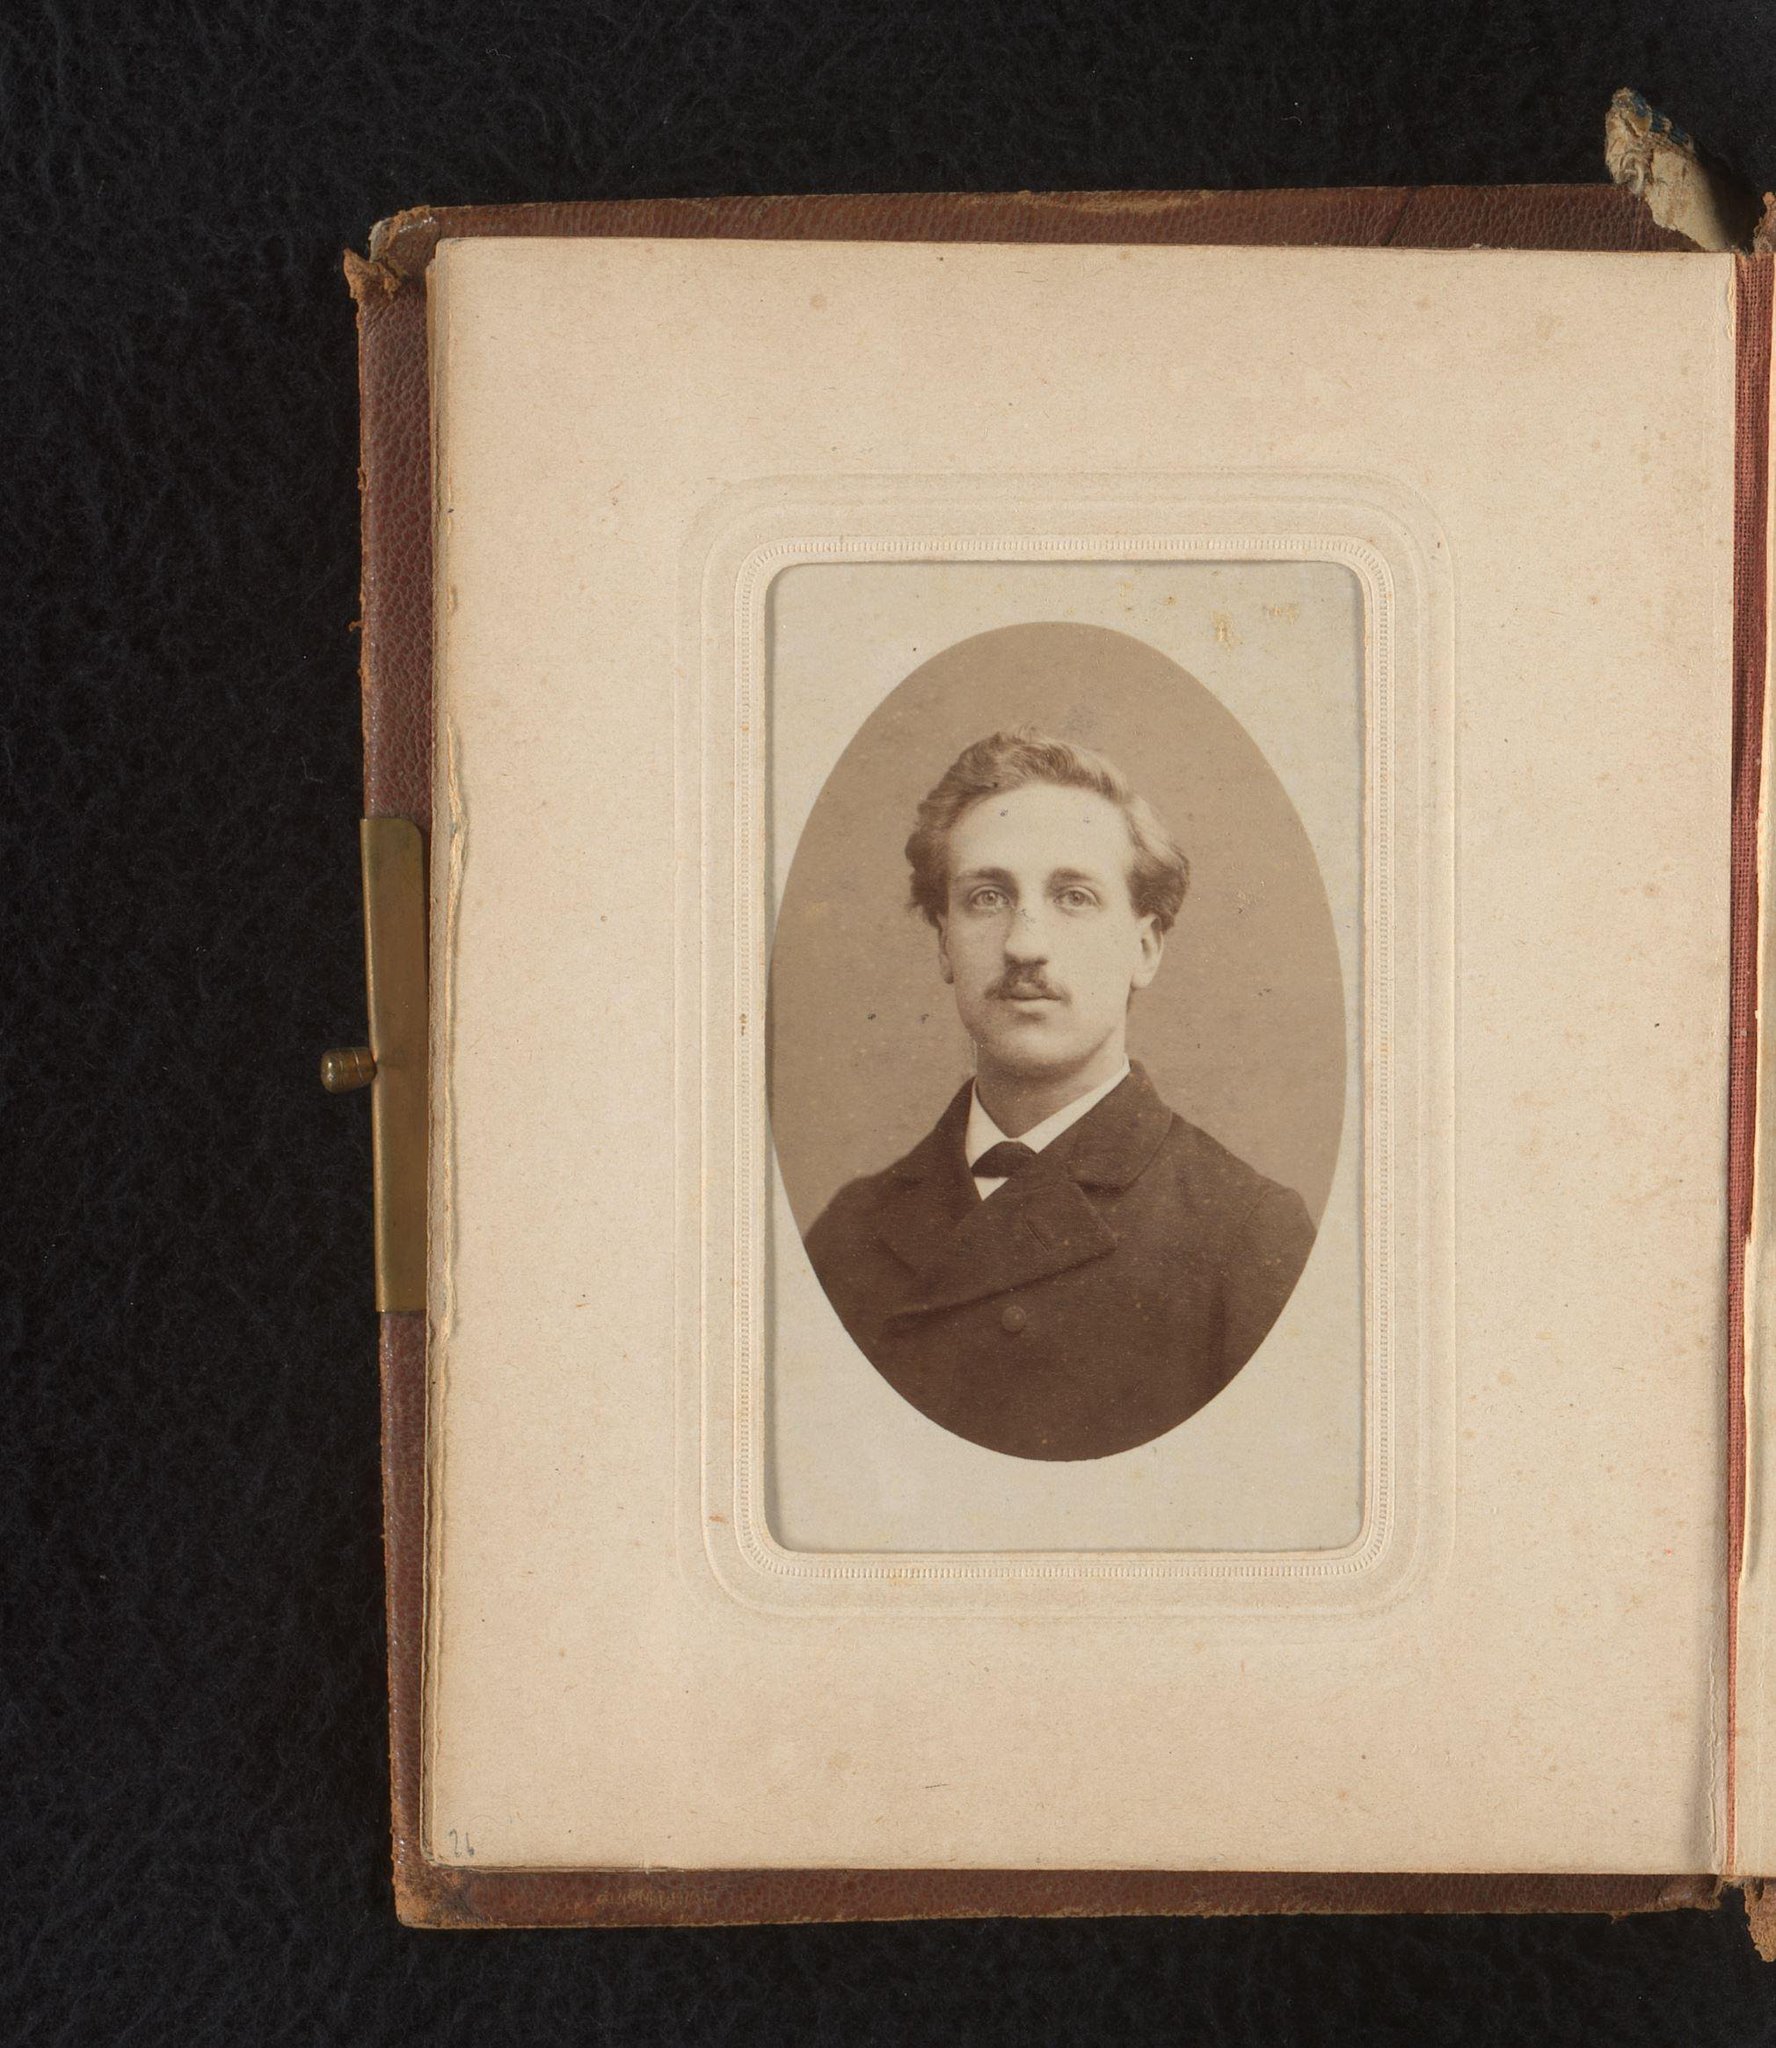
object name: carte de visite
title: Portret van een jongeman met snor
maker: johannes leonardus van der heijden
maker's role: fotograaf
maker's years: 1856-1937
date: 1878-1900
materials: cardboard, photographic support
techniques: albumen print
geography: amsterdam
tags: moustache, historical persons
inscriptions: inscription: ‘Johs. L. van der Heyden/ Photographie Artistique/ Heiligenweg hoek Singel 534/ Amsterdam’